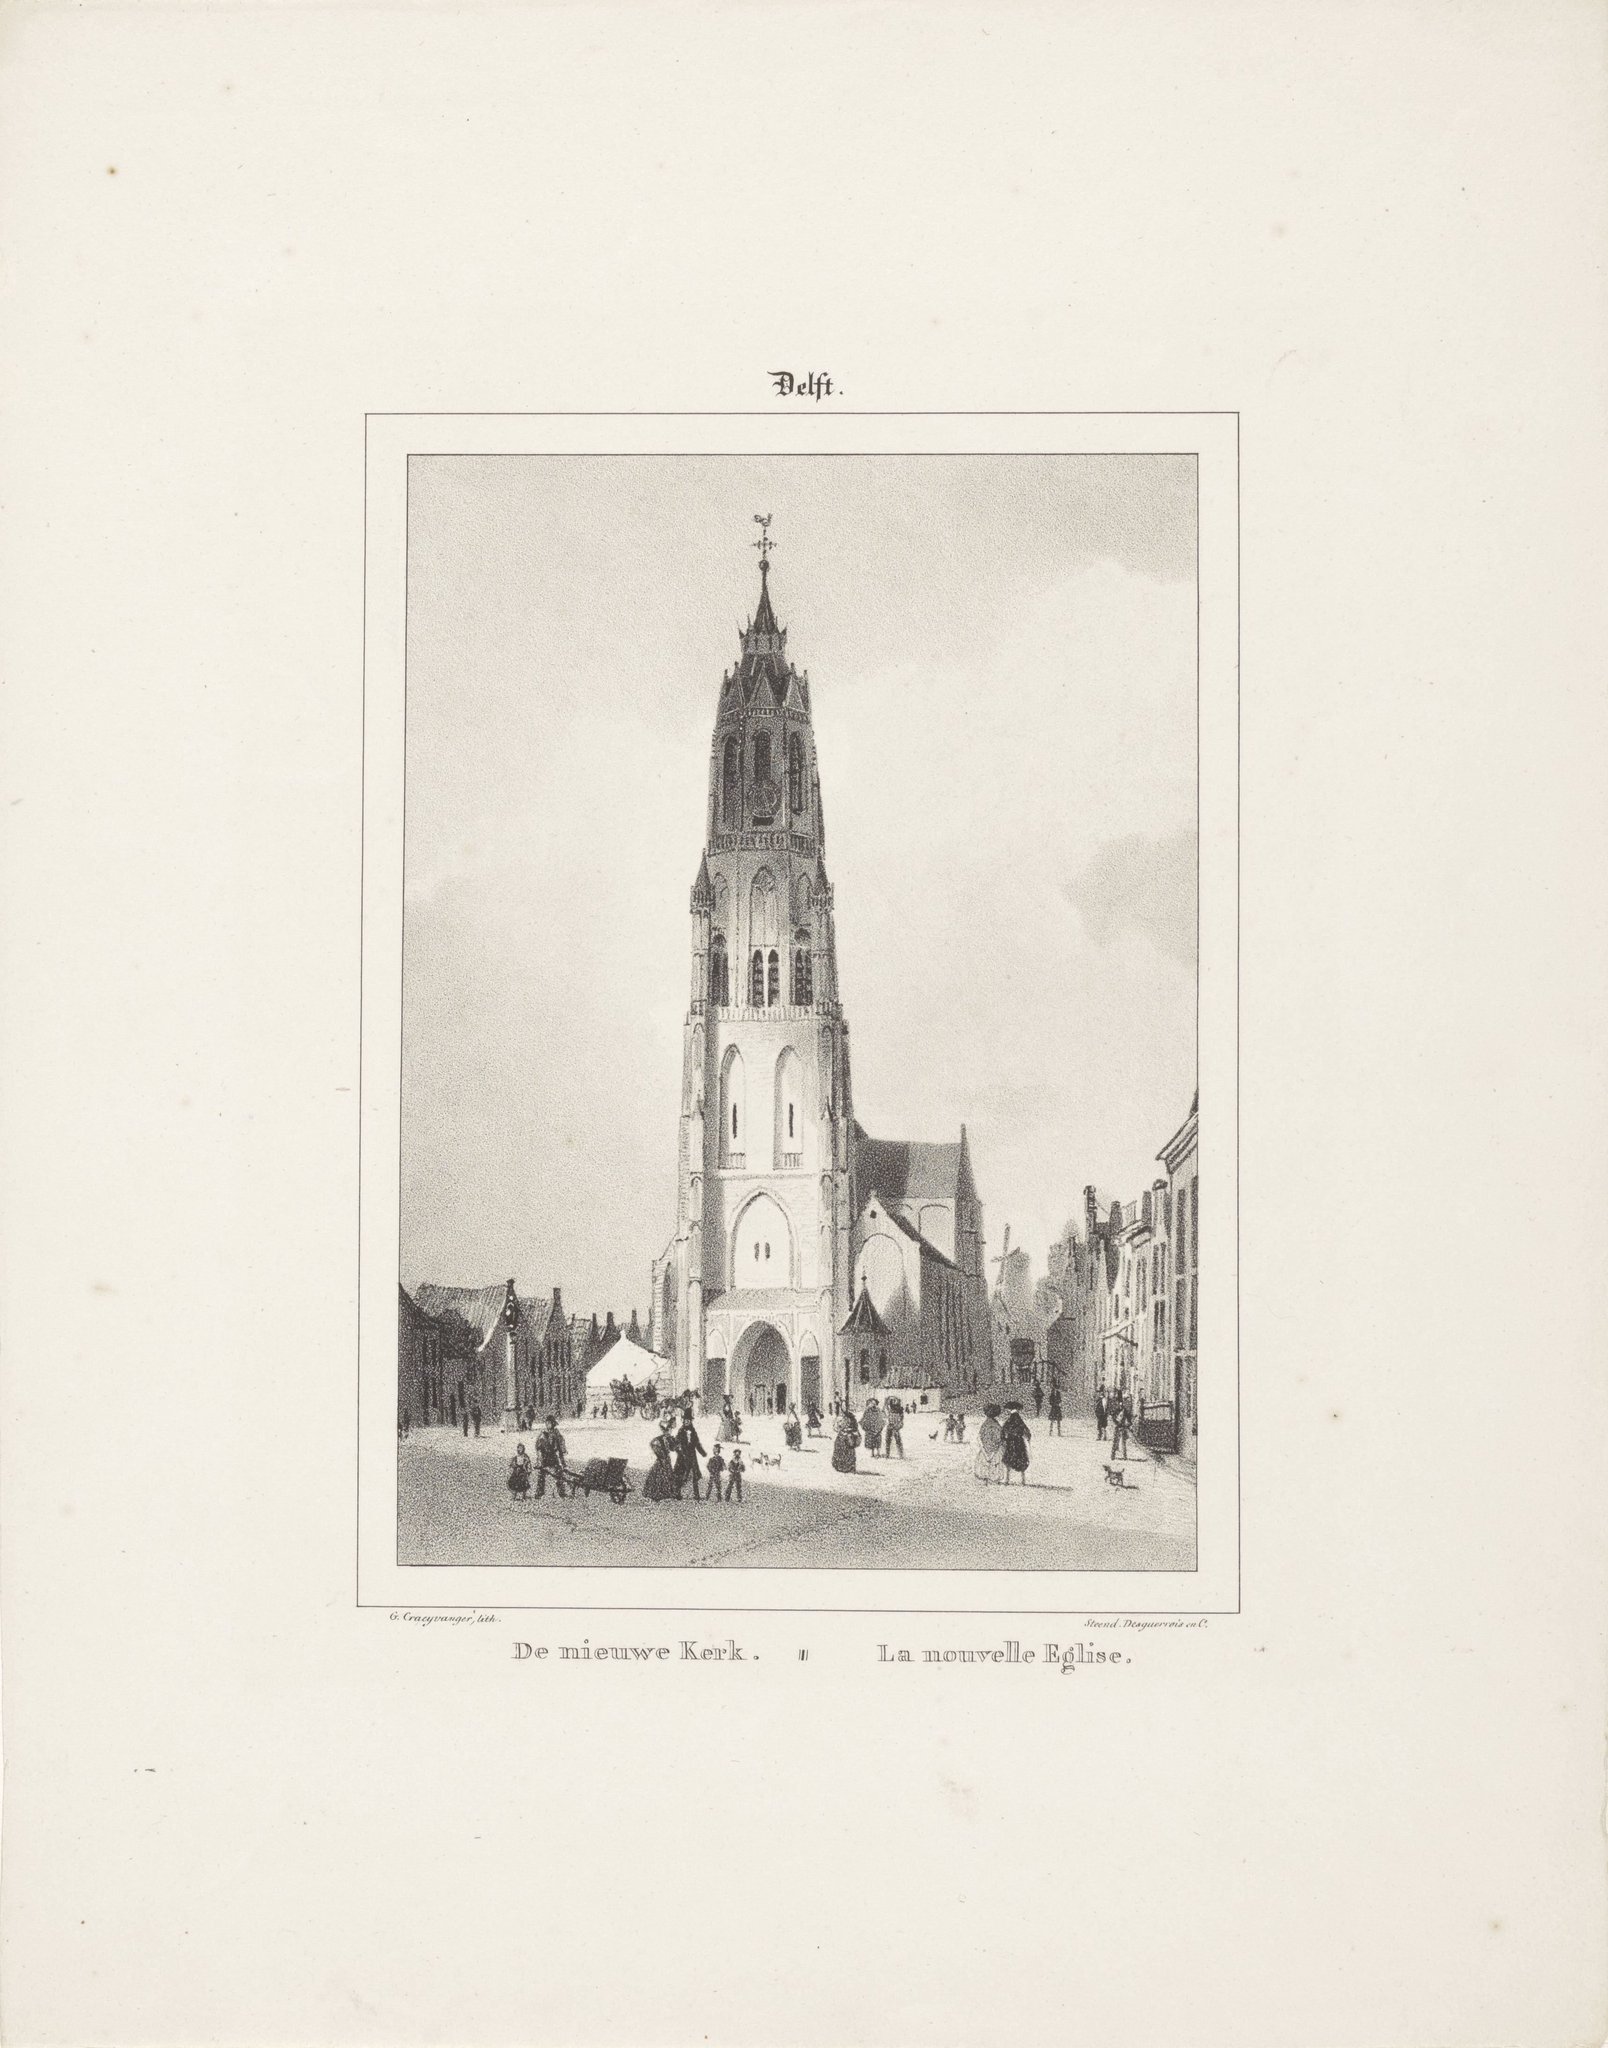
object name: print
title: Nieuwe Kerk in Delft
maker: gijsbertus craeyvanger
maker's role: draughtsman, print maker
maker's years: 1810-1895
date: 1820-1895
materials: paper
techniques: lithograph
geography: amsterdam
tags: church (exterior), city-view, and landscape with man-made constructions (+ city(-scape) with figures, staffage), windmill in landscape (+ city(-scape) with figures, staffage), delft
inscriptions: collector's mark: Lugt 2228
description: De toren van de kerk is gehuld in schaduw. Op het plein ervoor staan en lopen figuren. Rechts van de kerk, aan het einde van een straat, staat een windmolen.